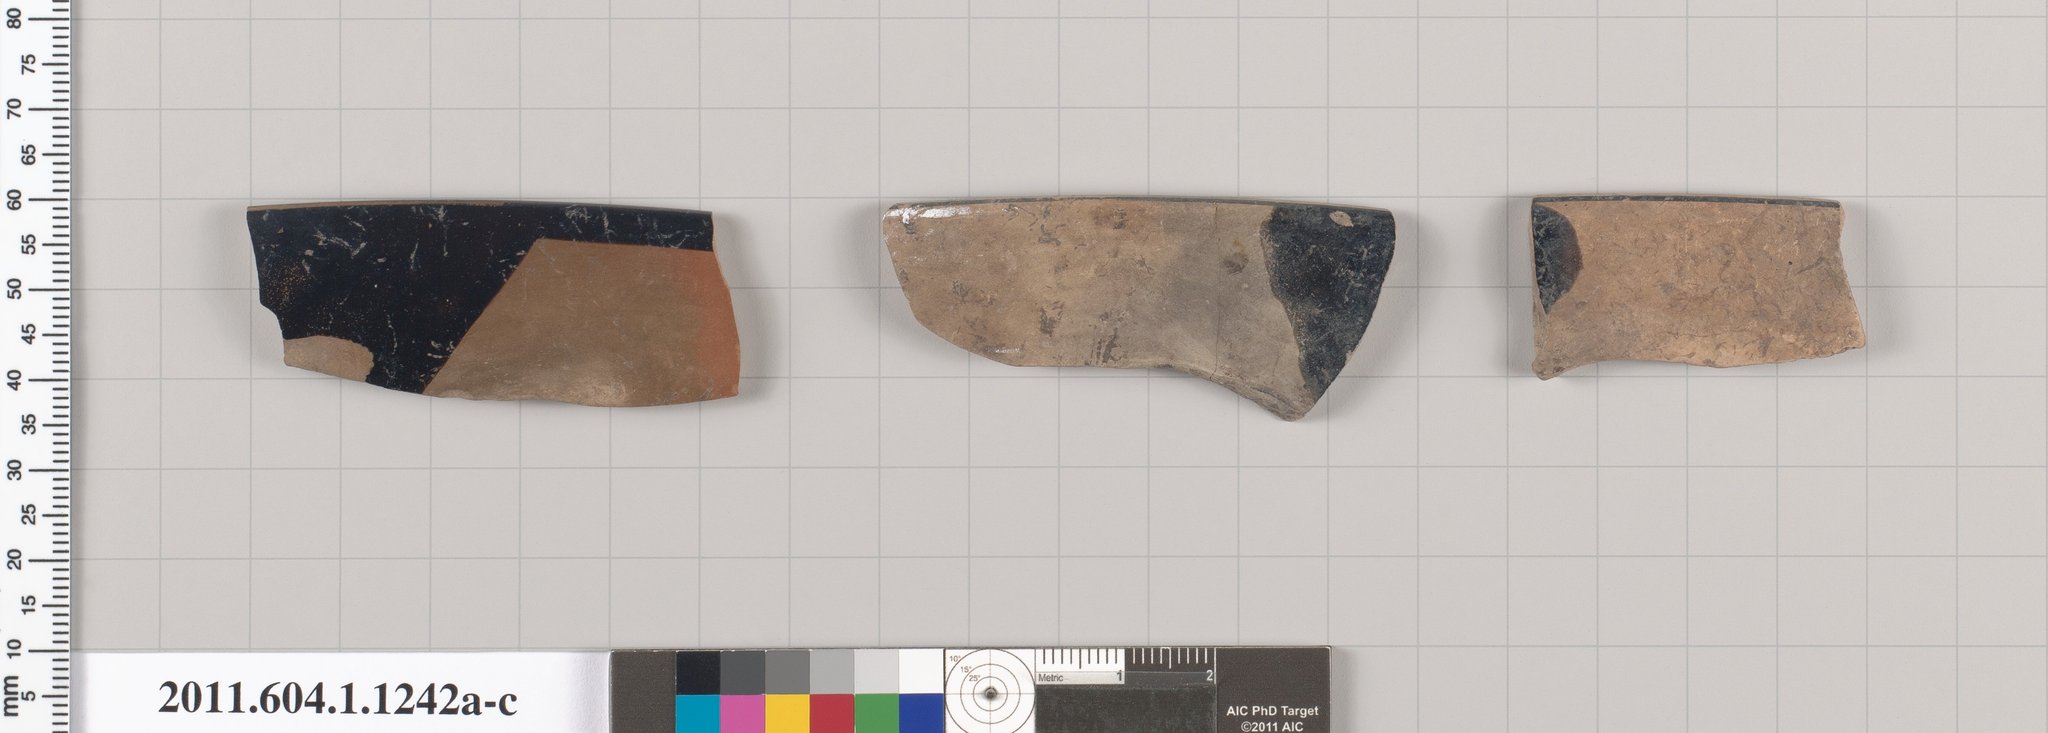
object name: kylix fragment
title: Terracotta rim fragments of kylikes (drinking cup)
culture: greek, attic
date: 500-401 BCE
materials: terracotta